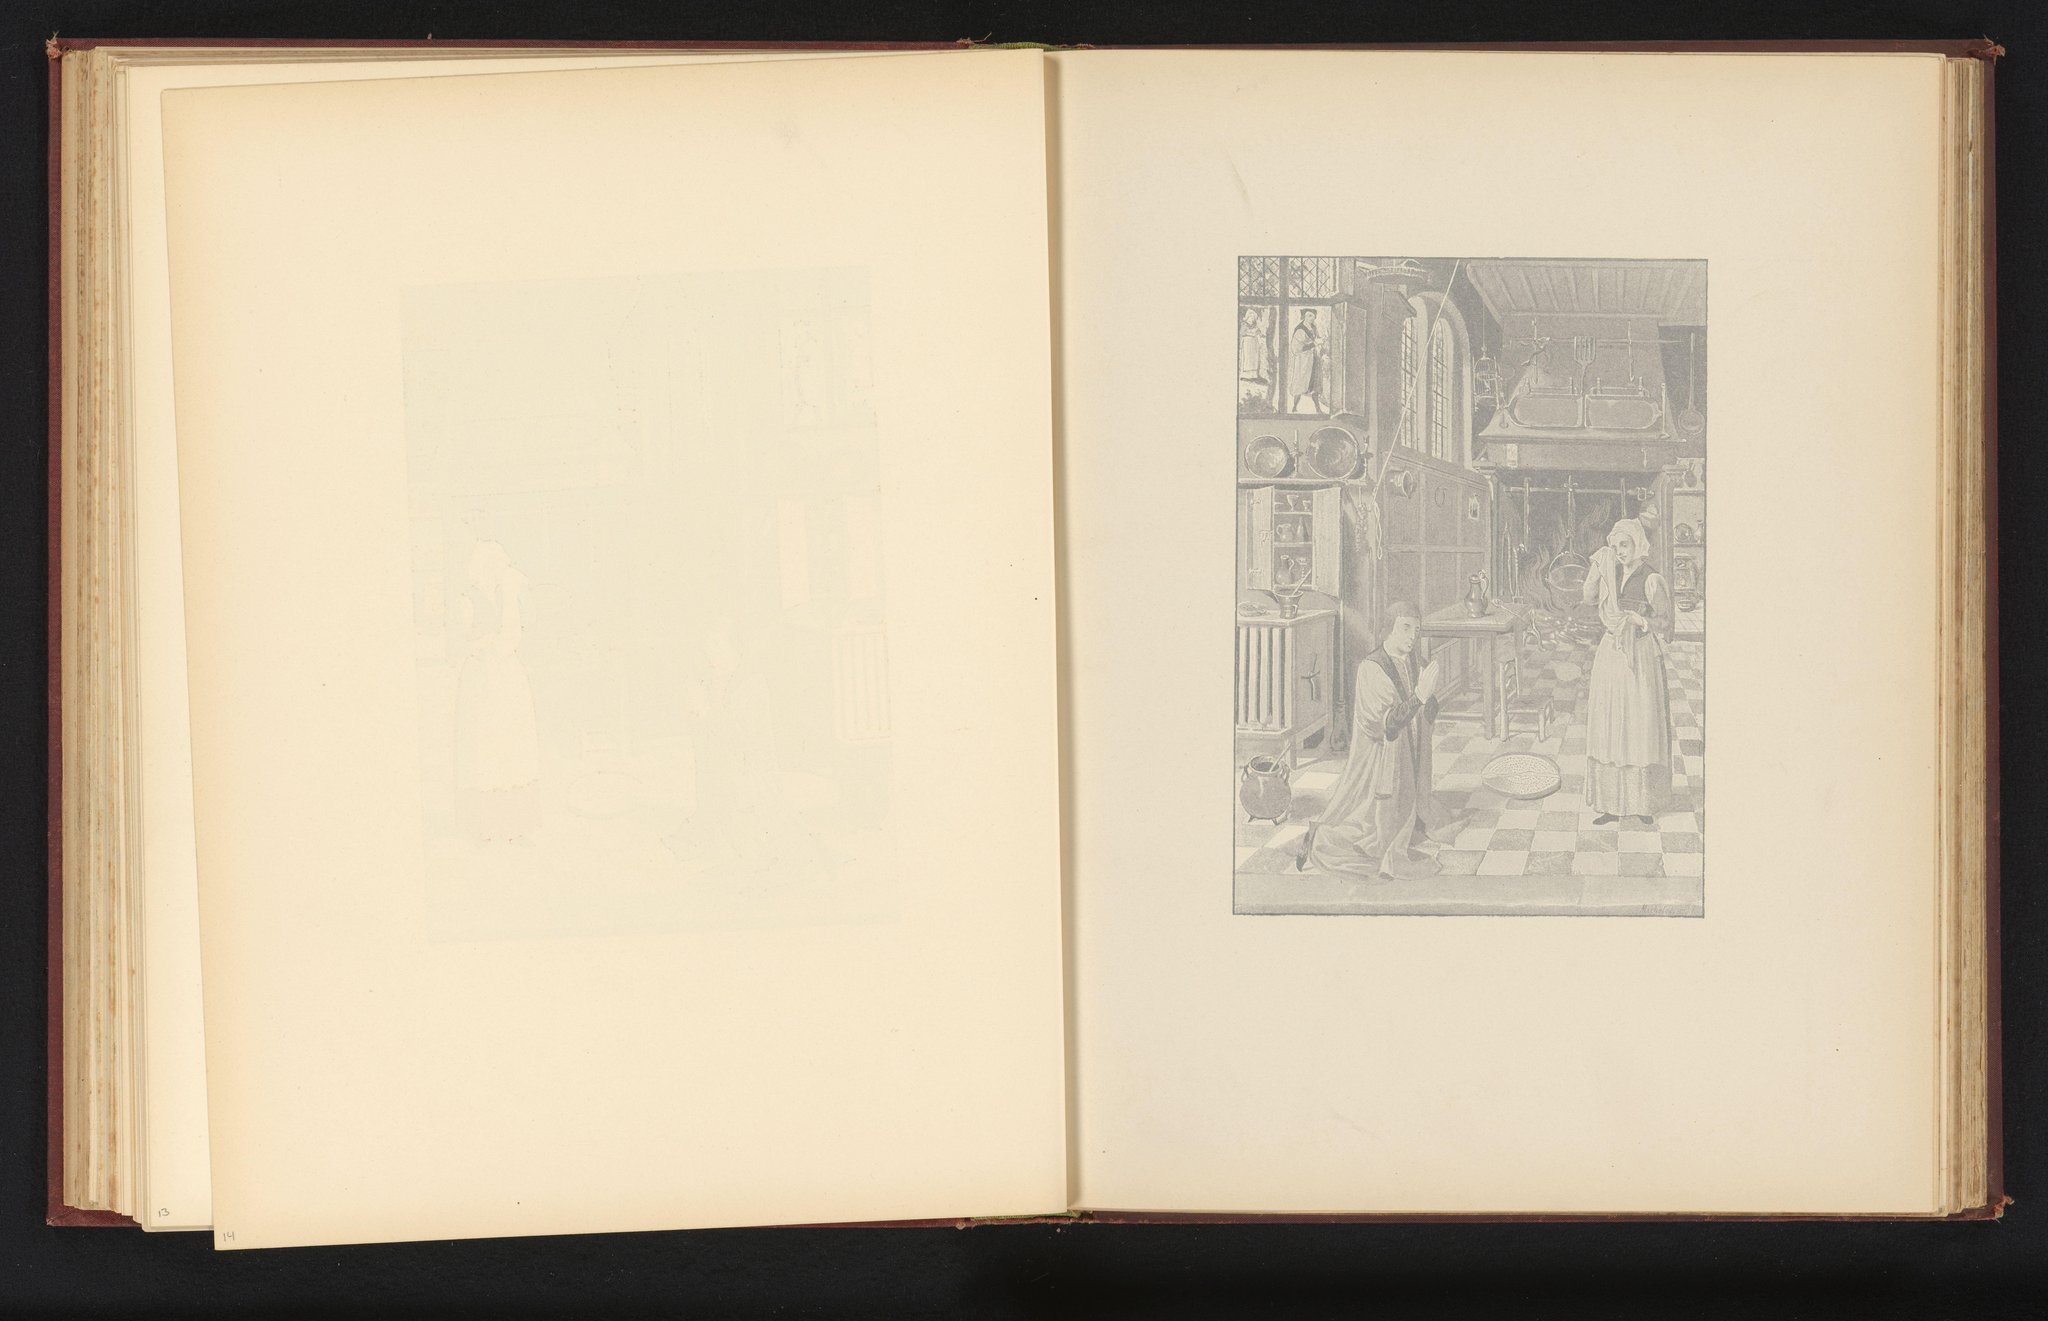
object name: photomechanical print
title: Reproductie van het schilderij Het mirakel van de gebroken zeef, sleutel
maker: michelet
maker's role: print maker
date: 1889-1894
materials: paper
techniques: autotype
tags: kitchen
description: Prent op vijfentwintigste ongenummerde pagina na pagina 104.